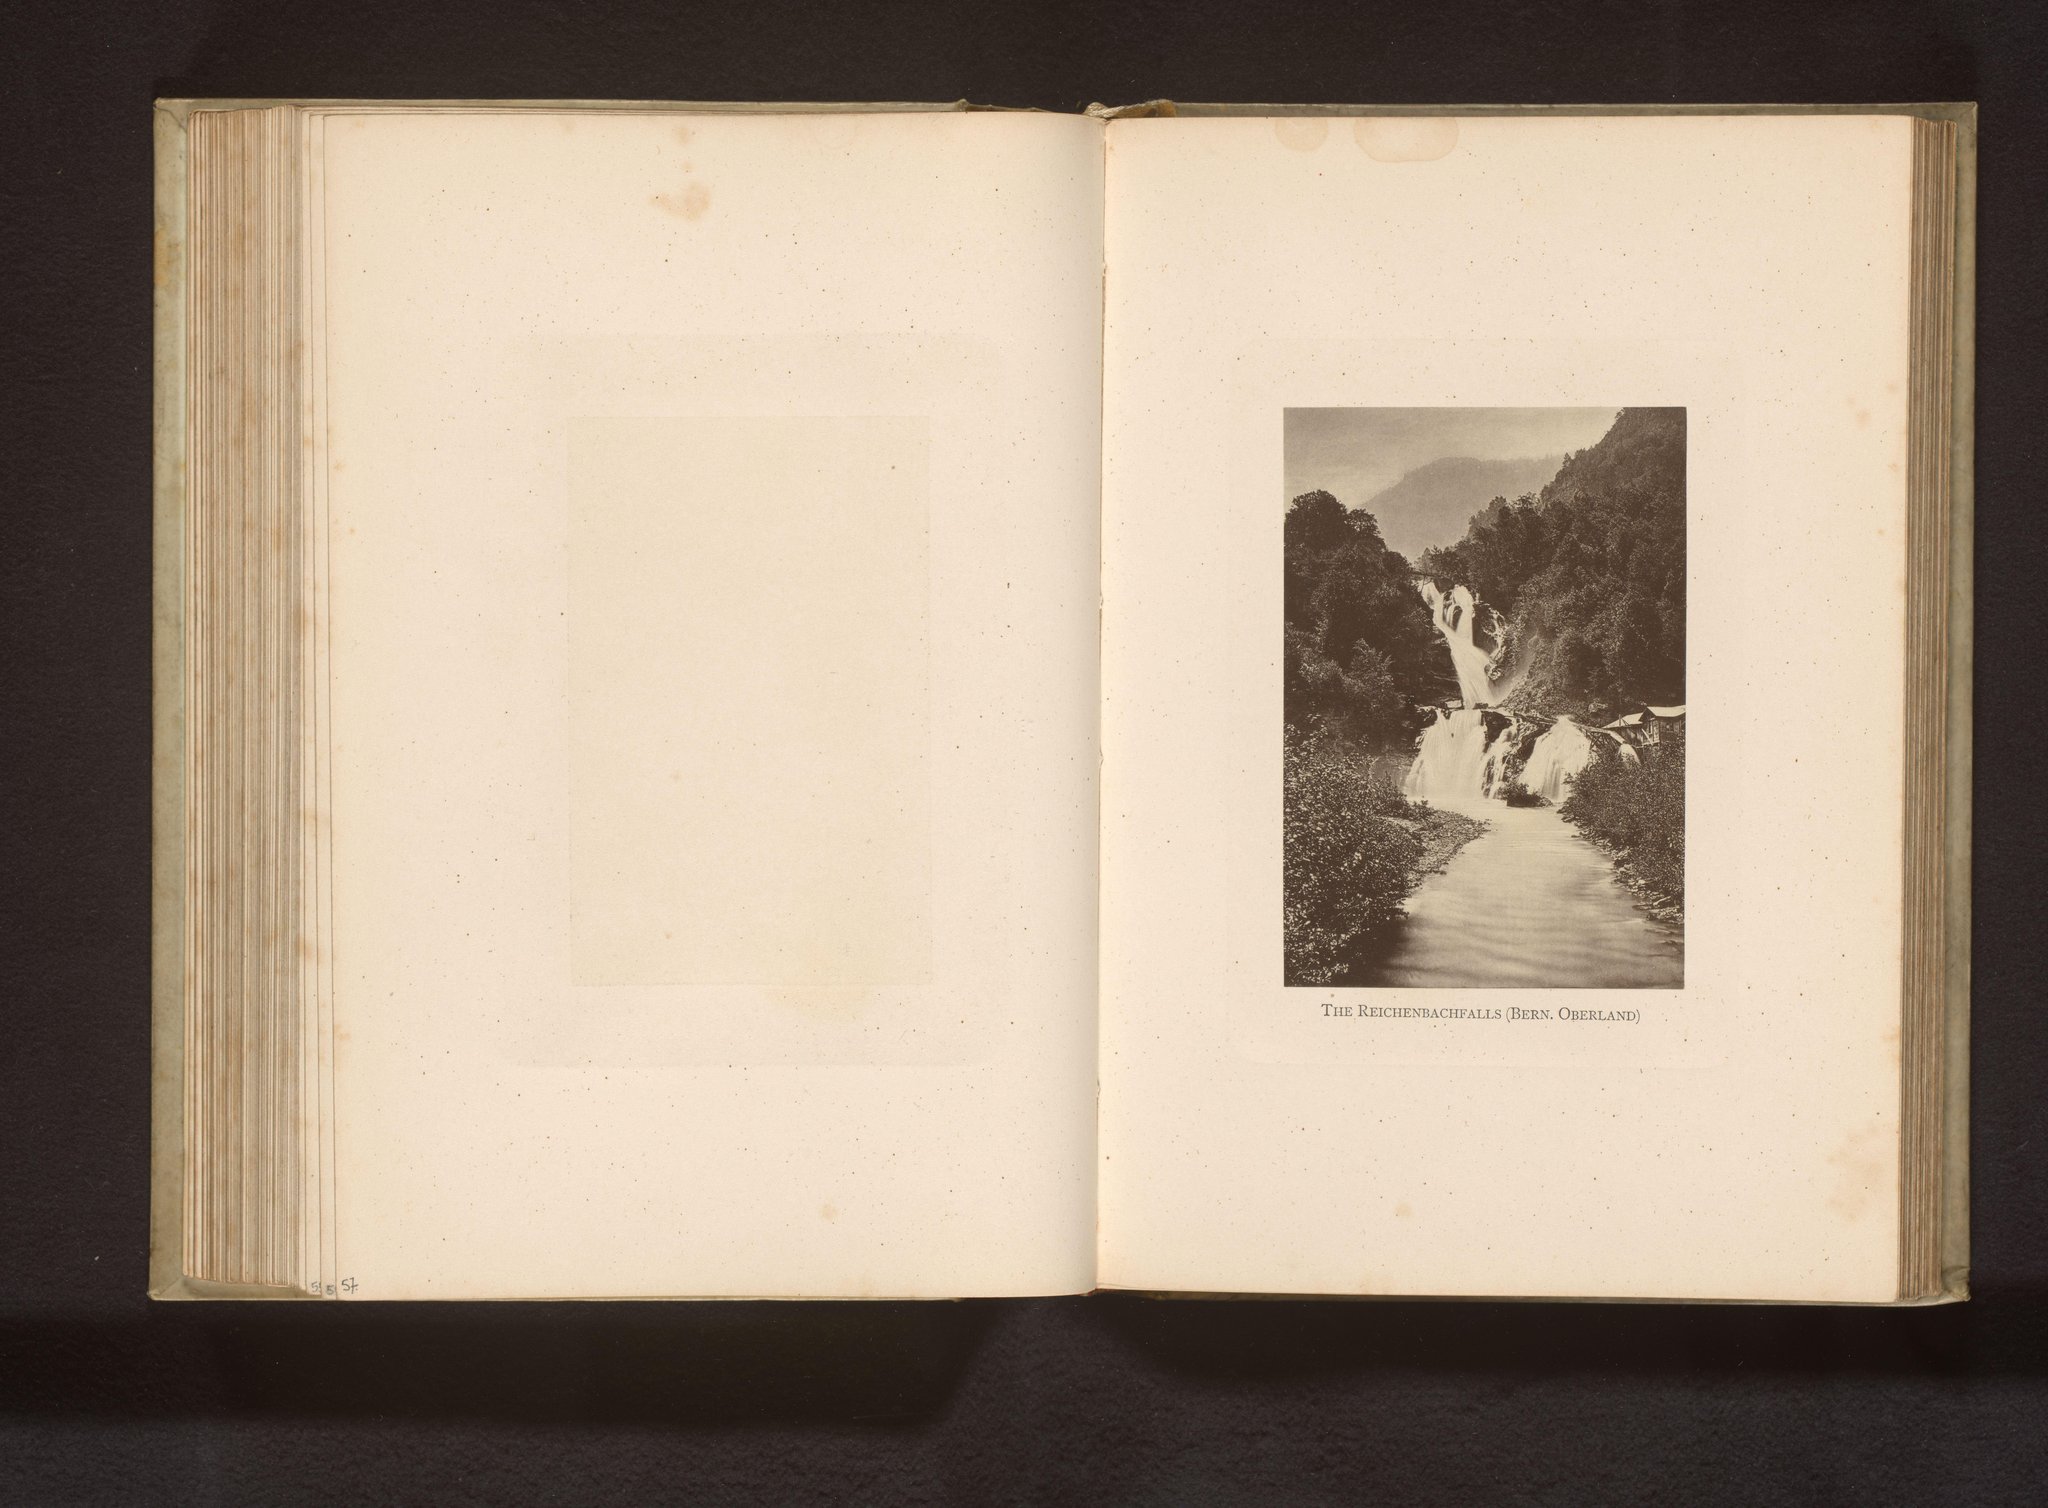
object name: page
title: Gezicht op de Reichenbachwaterval in het Berner Oberland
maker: Anonymous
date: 1874-1884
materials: paper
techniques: photograph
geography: bern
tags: waterfall